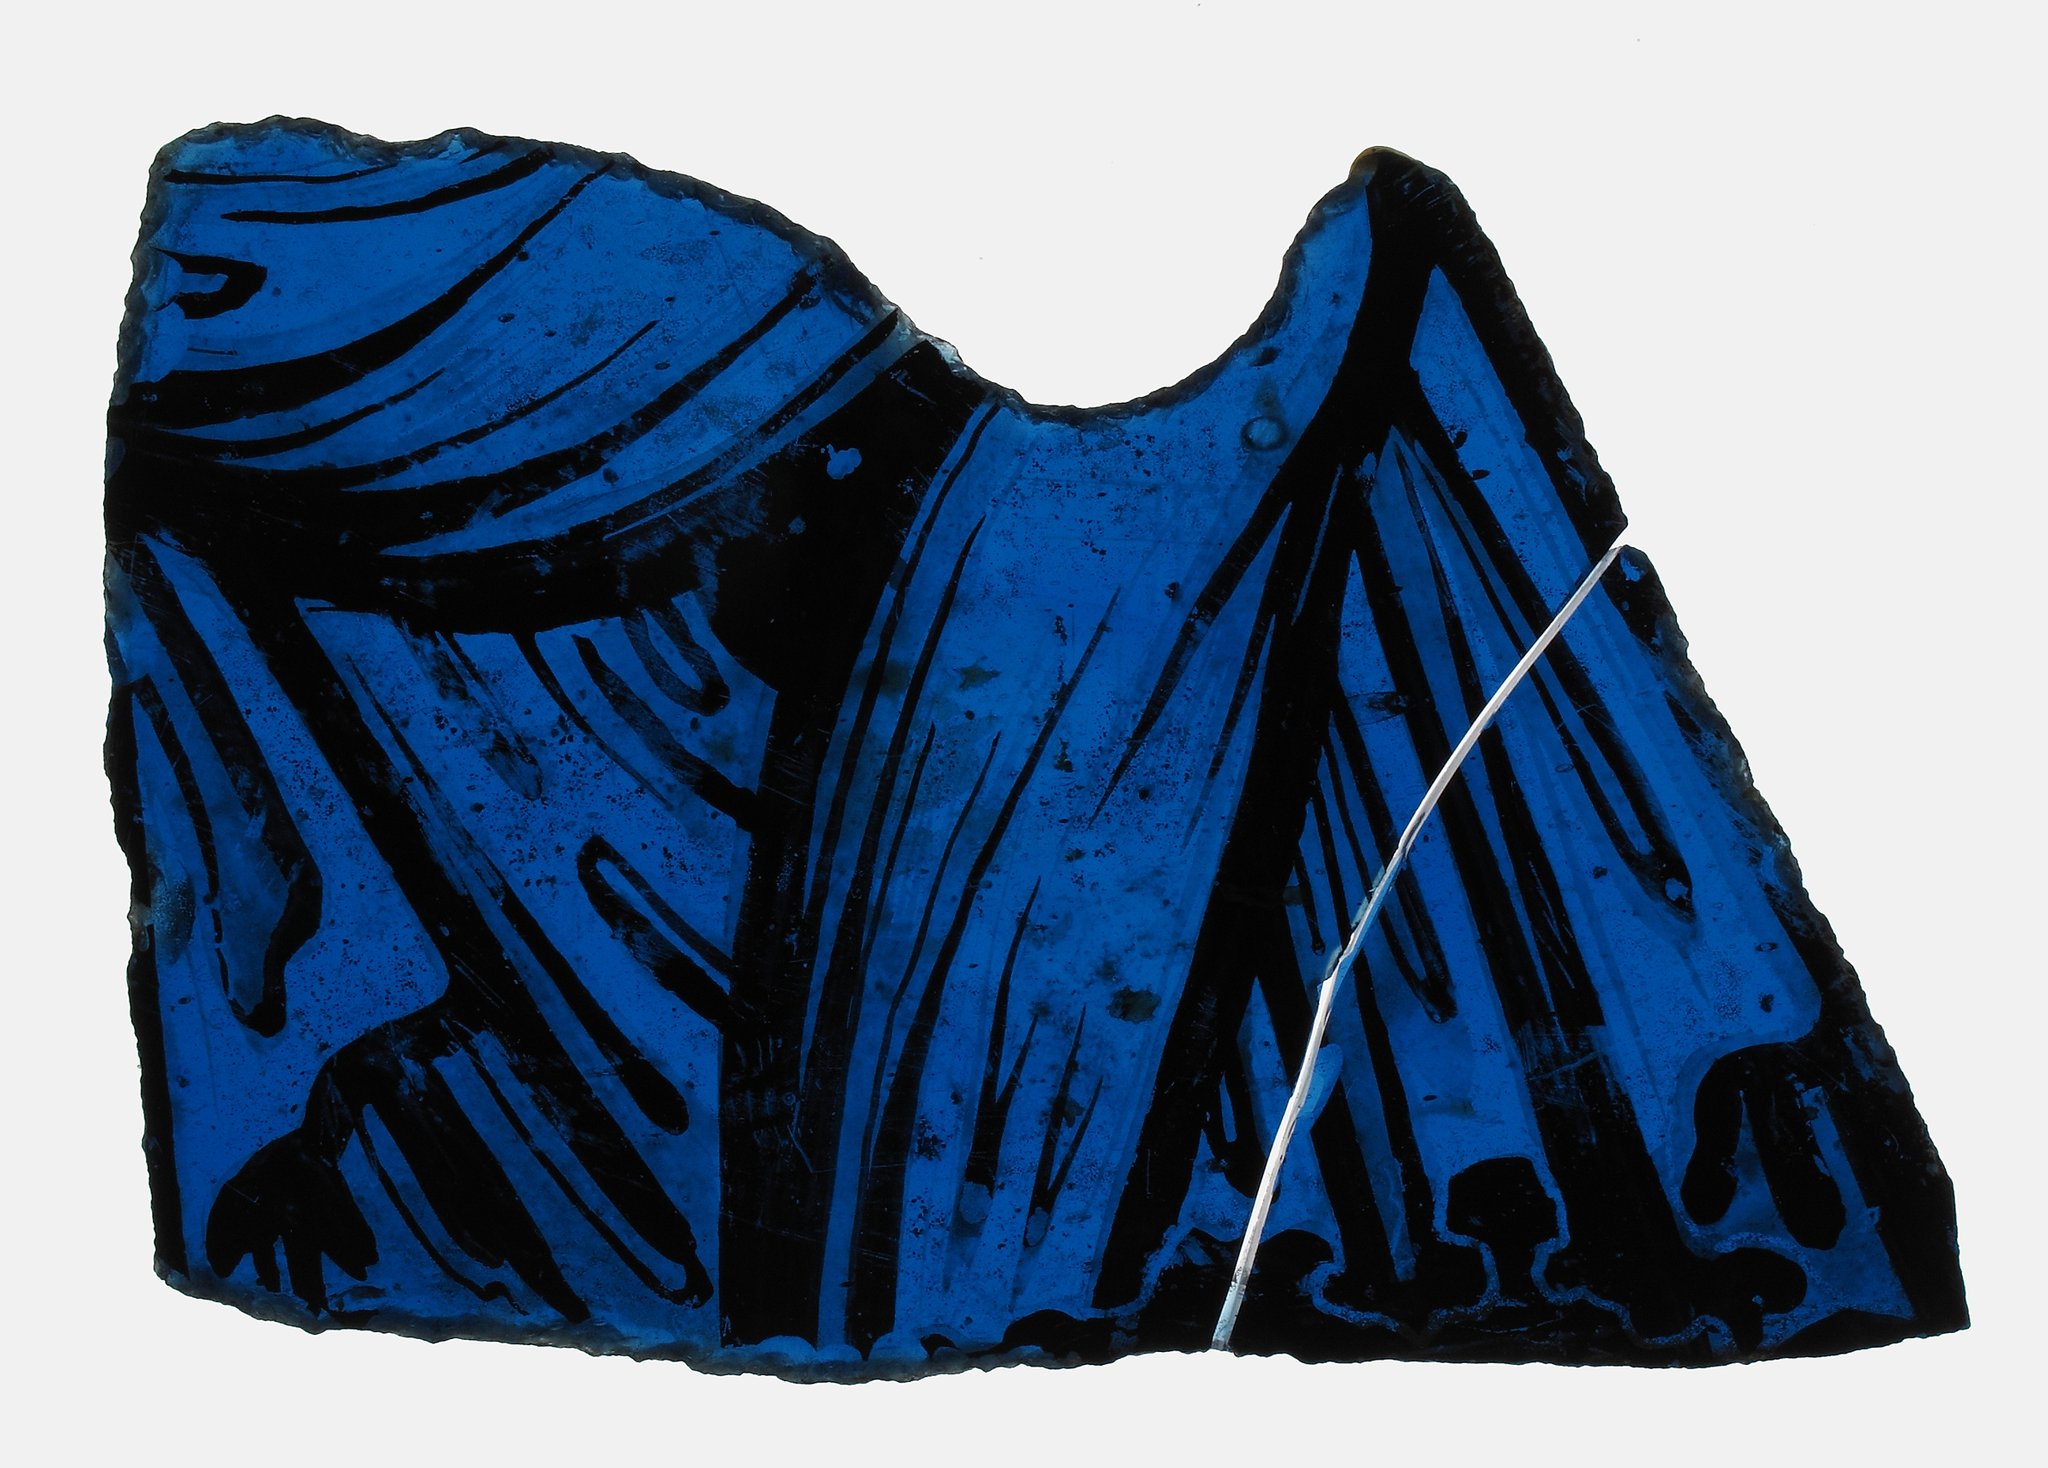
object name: fragment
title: Glass Fragment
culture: european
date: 1201-1300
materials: glass, metal